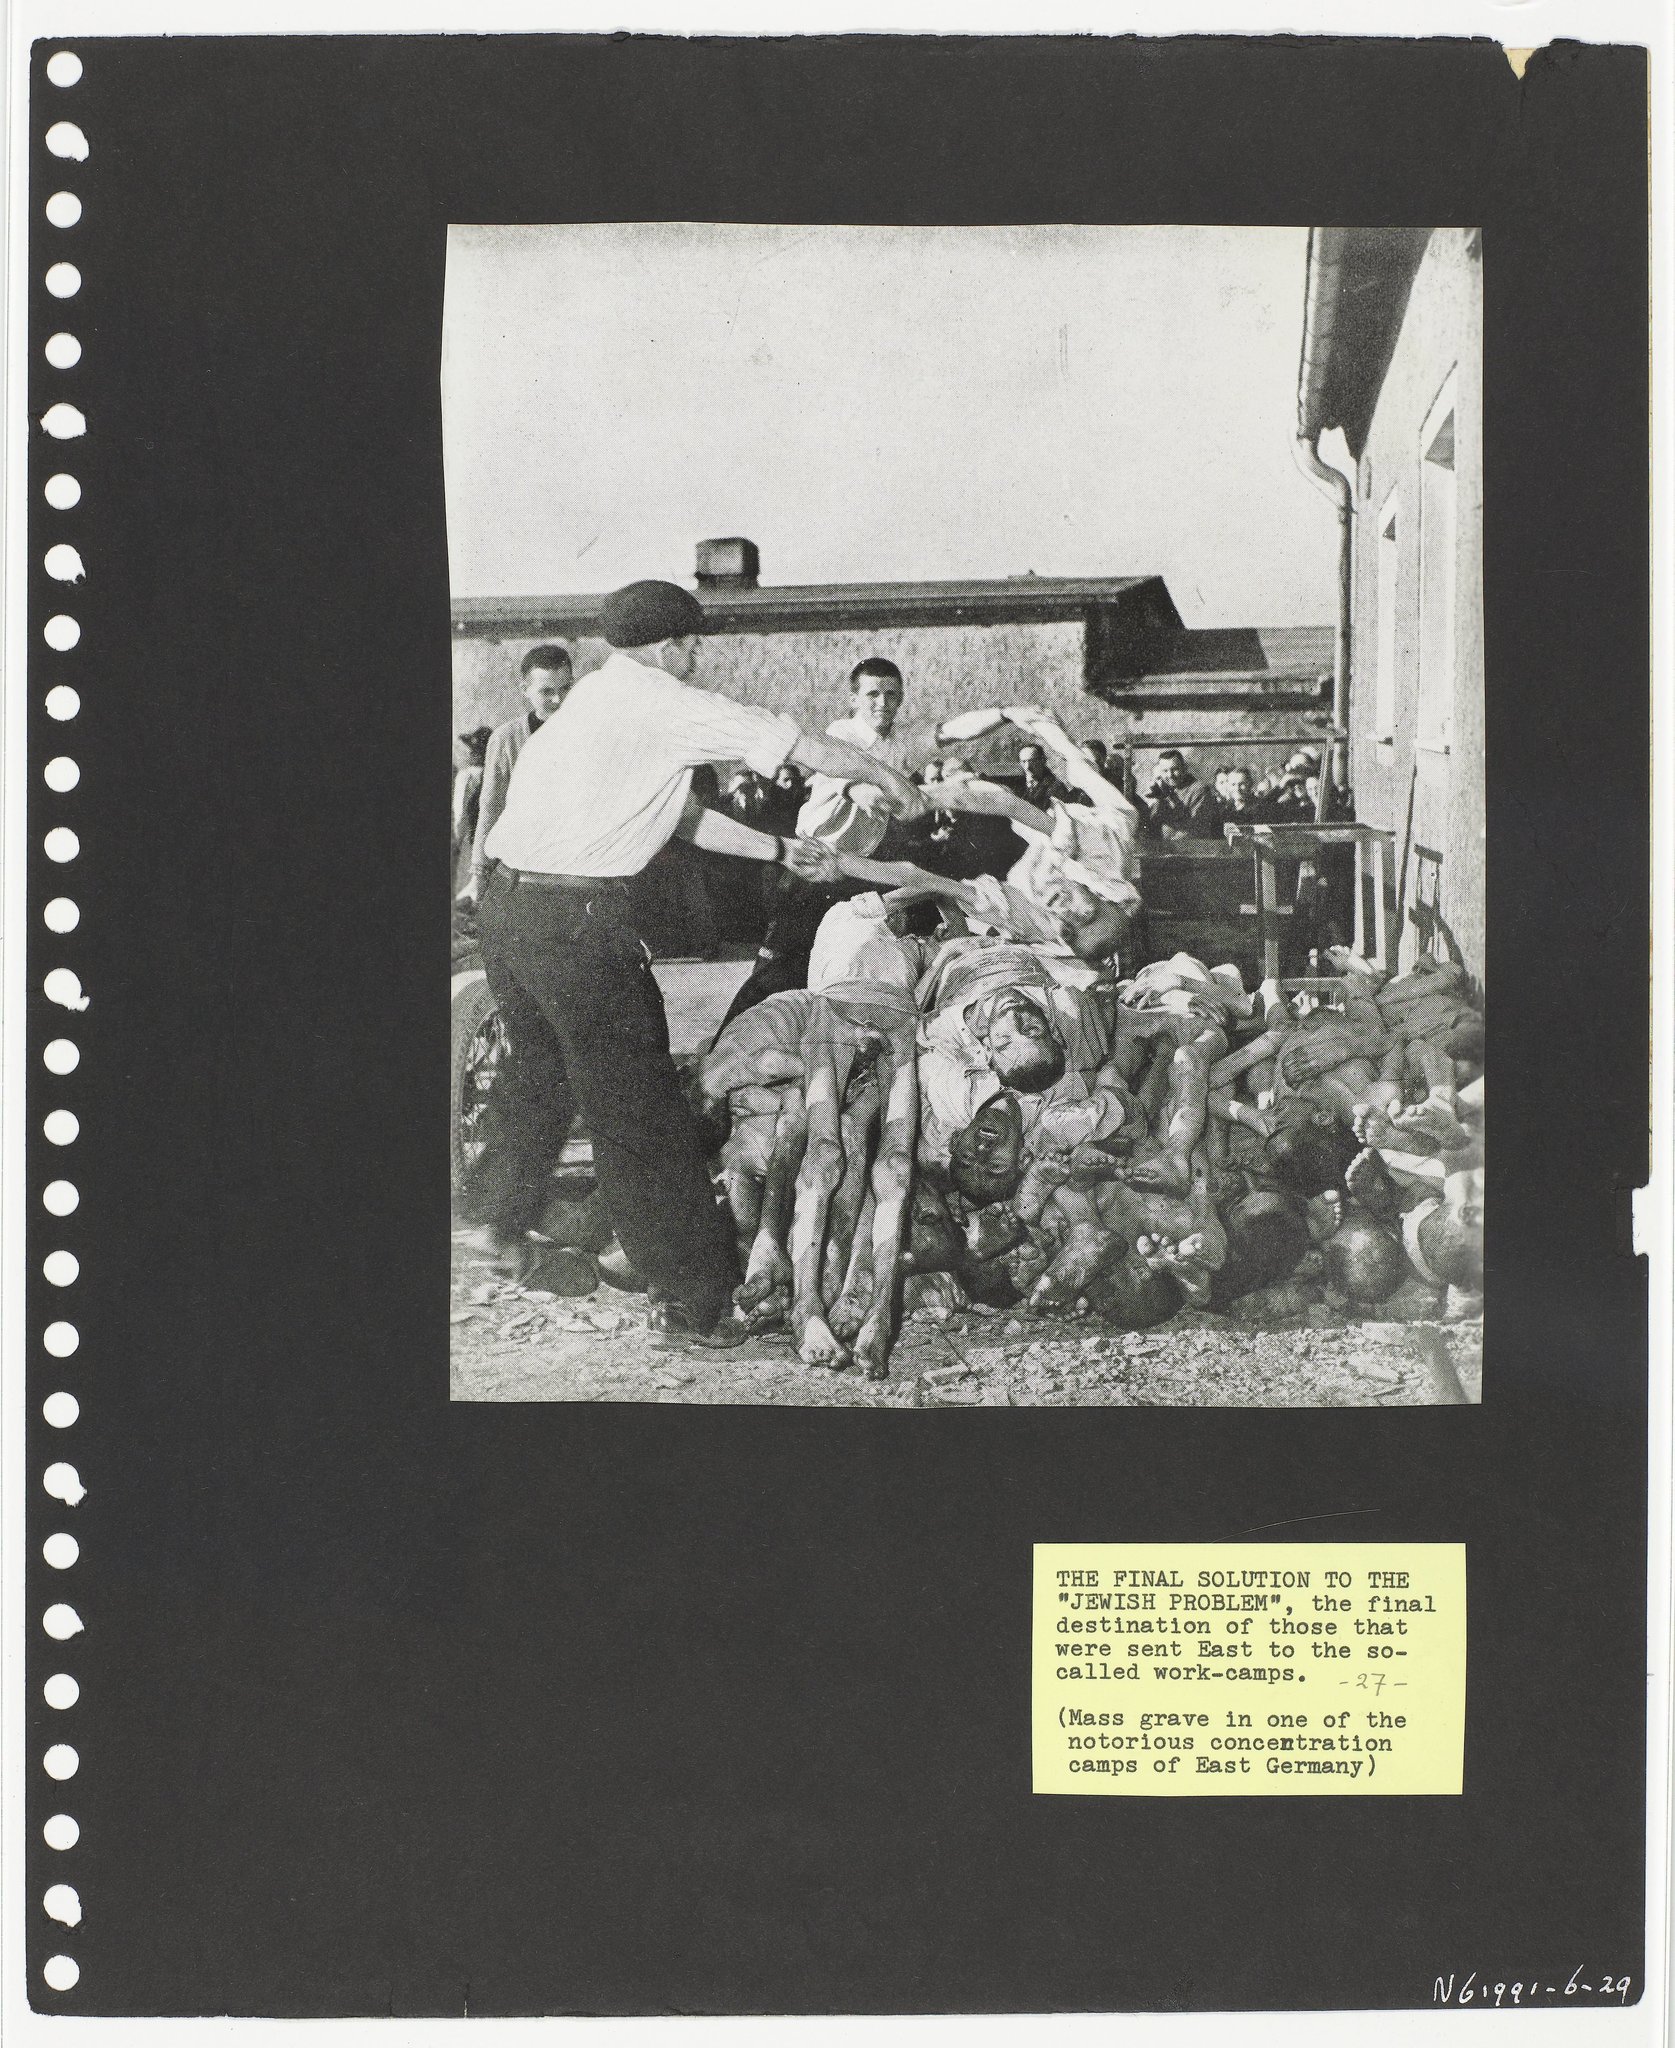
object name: photograph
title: Foto en collageboek 'De Verborgen Camera'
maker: Anonymous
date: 1942-1945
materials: paper, plastic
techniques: photography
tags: amsterdam, tonny van renterghem, fritz kahlenberg, concentration camp, mass-grave, underground movement, partisans, netherlands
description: Foto van een foto: vermoorde joden worden in een massagraf gelegd.